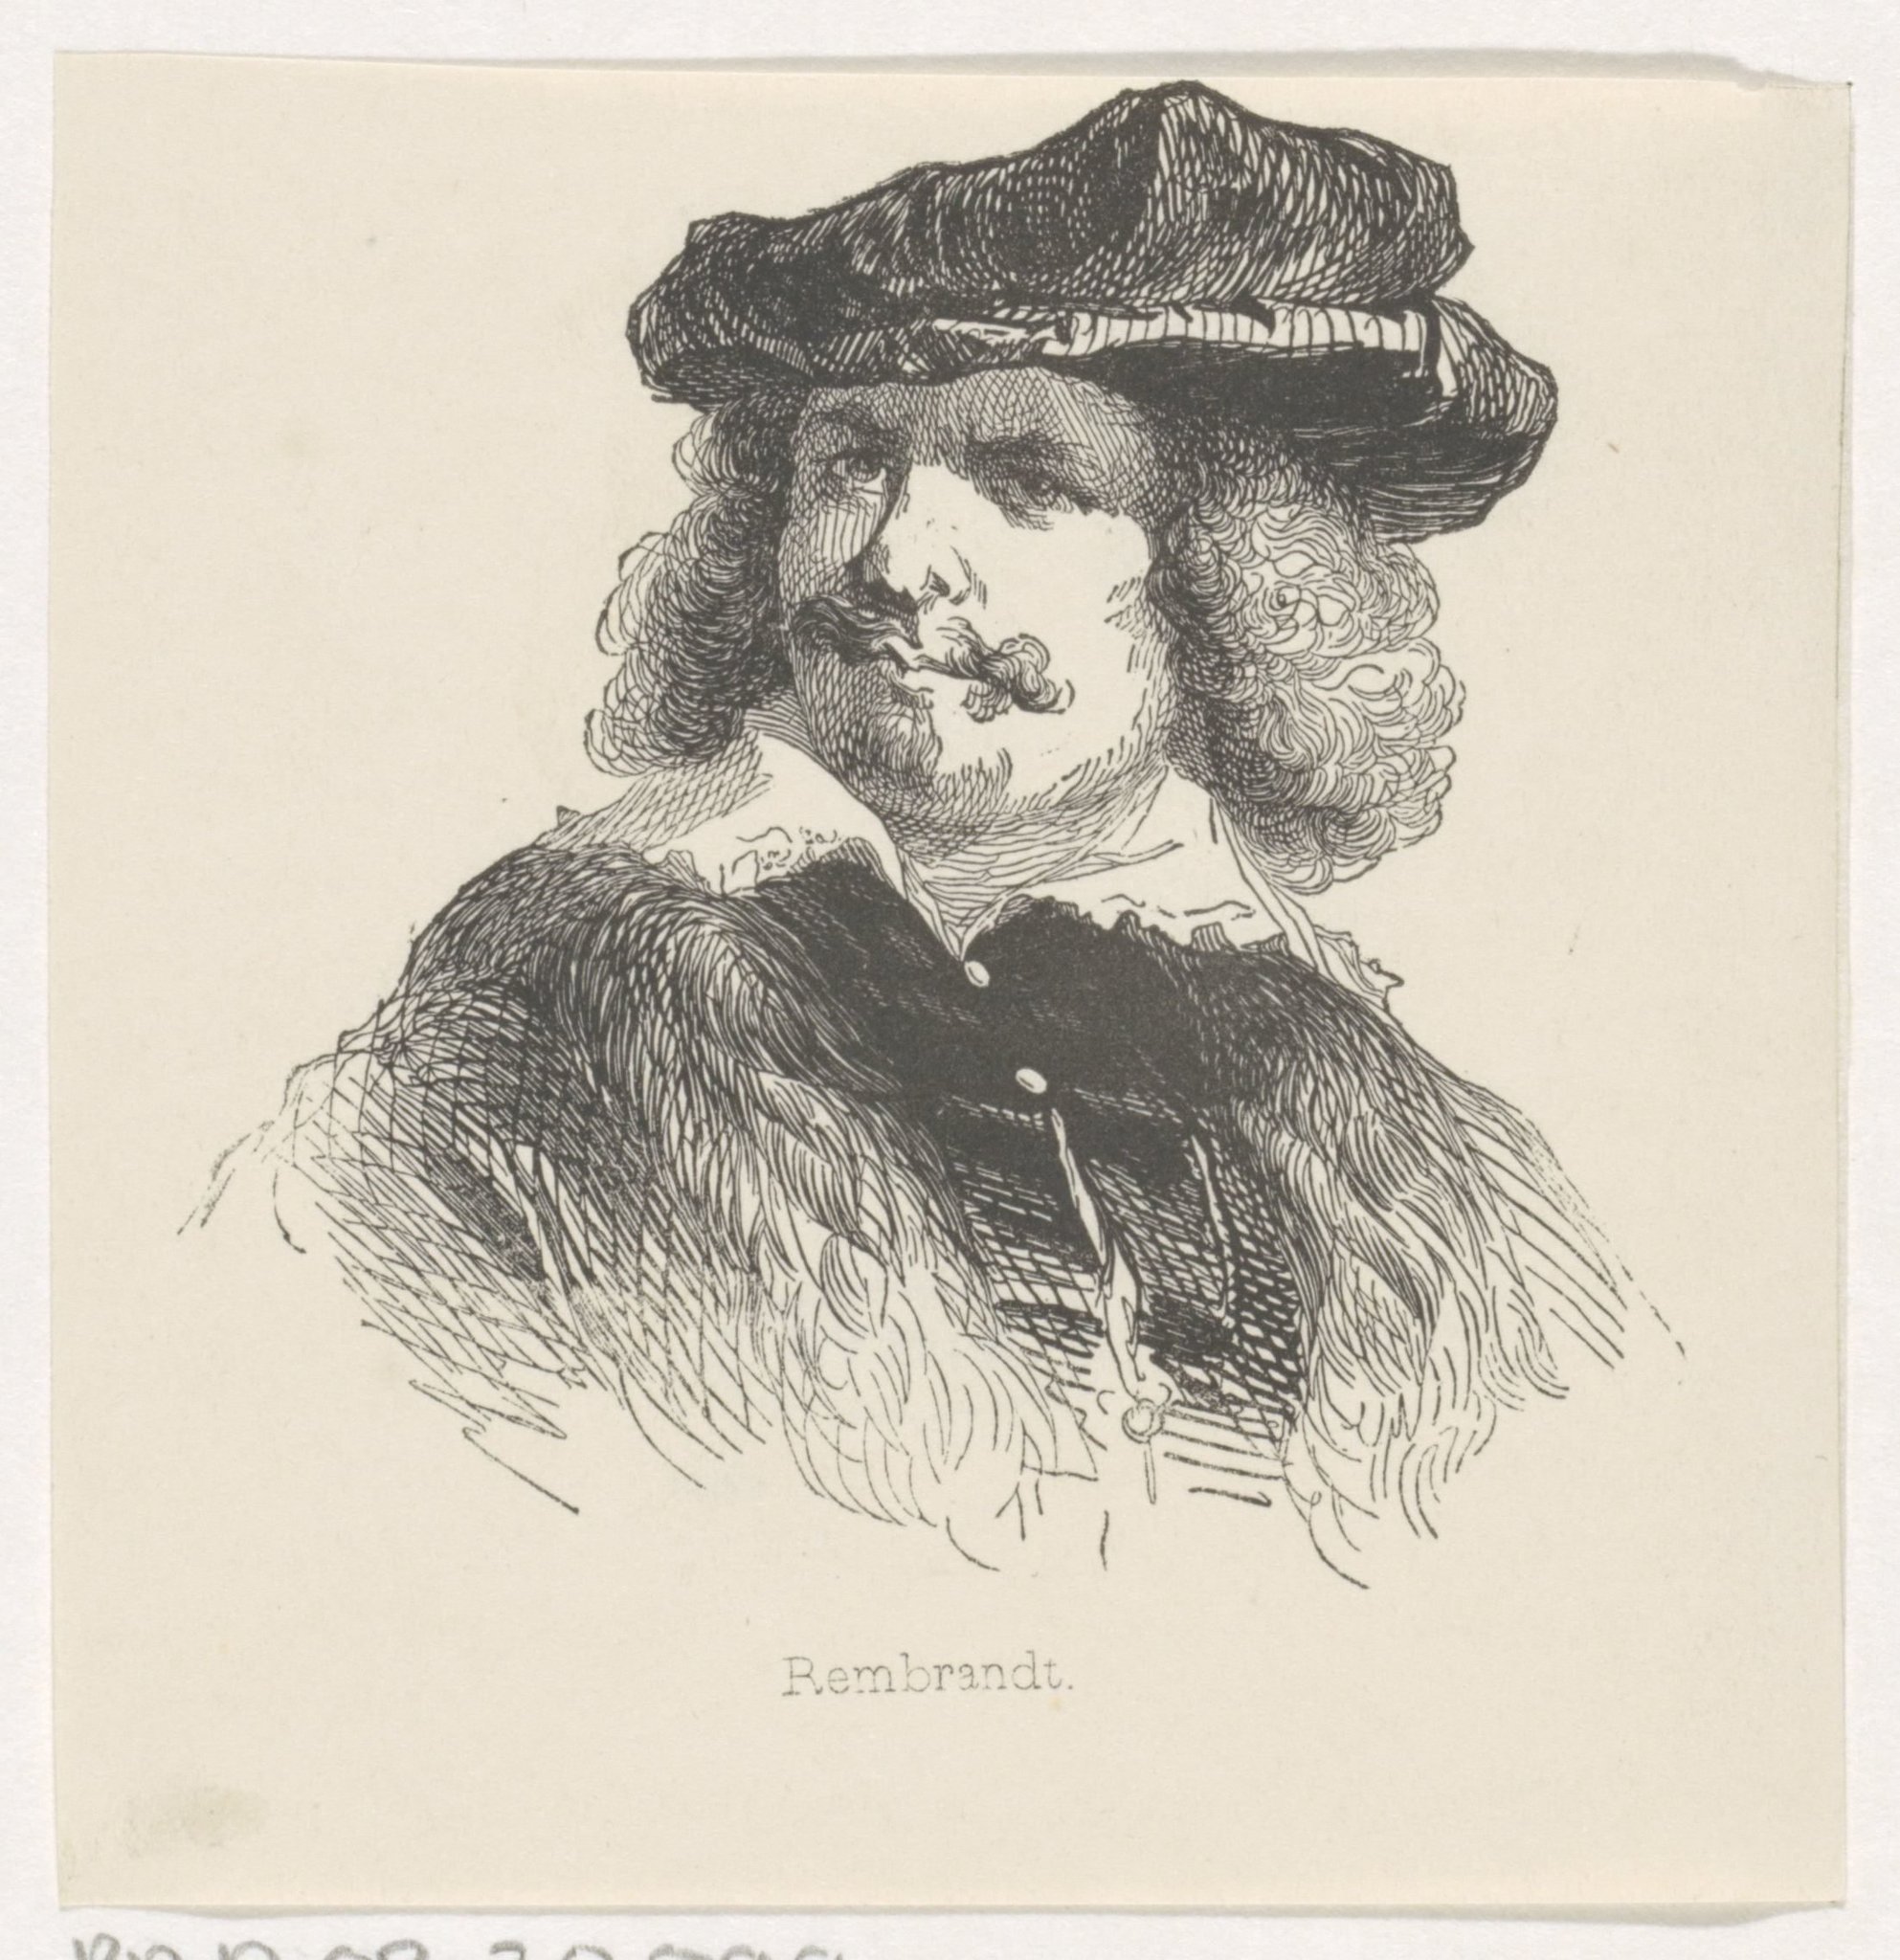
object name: book illustration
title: Portret van Rembrandt Harmensz. van Rijn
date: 1842-1843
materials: paper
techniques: engraving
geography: amsterdam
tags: leiden, painter, print maker, rembrandt van rijn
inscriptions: collector's mark: Lugt 2228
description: Prent uit: Immerzeel, Johannes. De levens en werken der Hollandsche en Vlaamsche kunstschilders, beeldhouwers, graveurs en bouwmeesters : van het begin der vijftiende eeuw tot heden. Amsterdam: J.C. van Kesteren, 1842-1843.